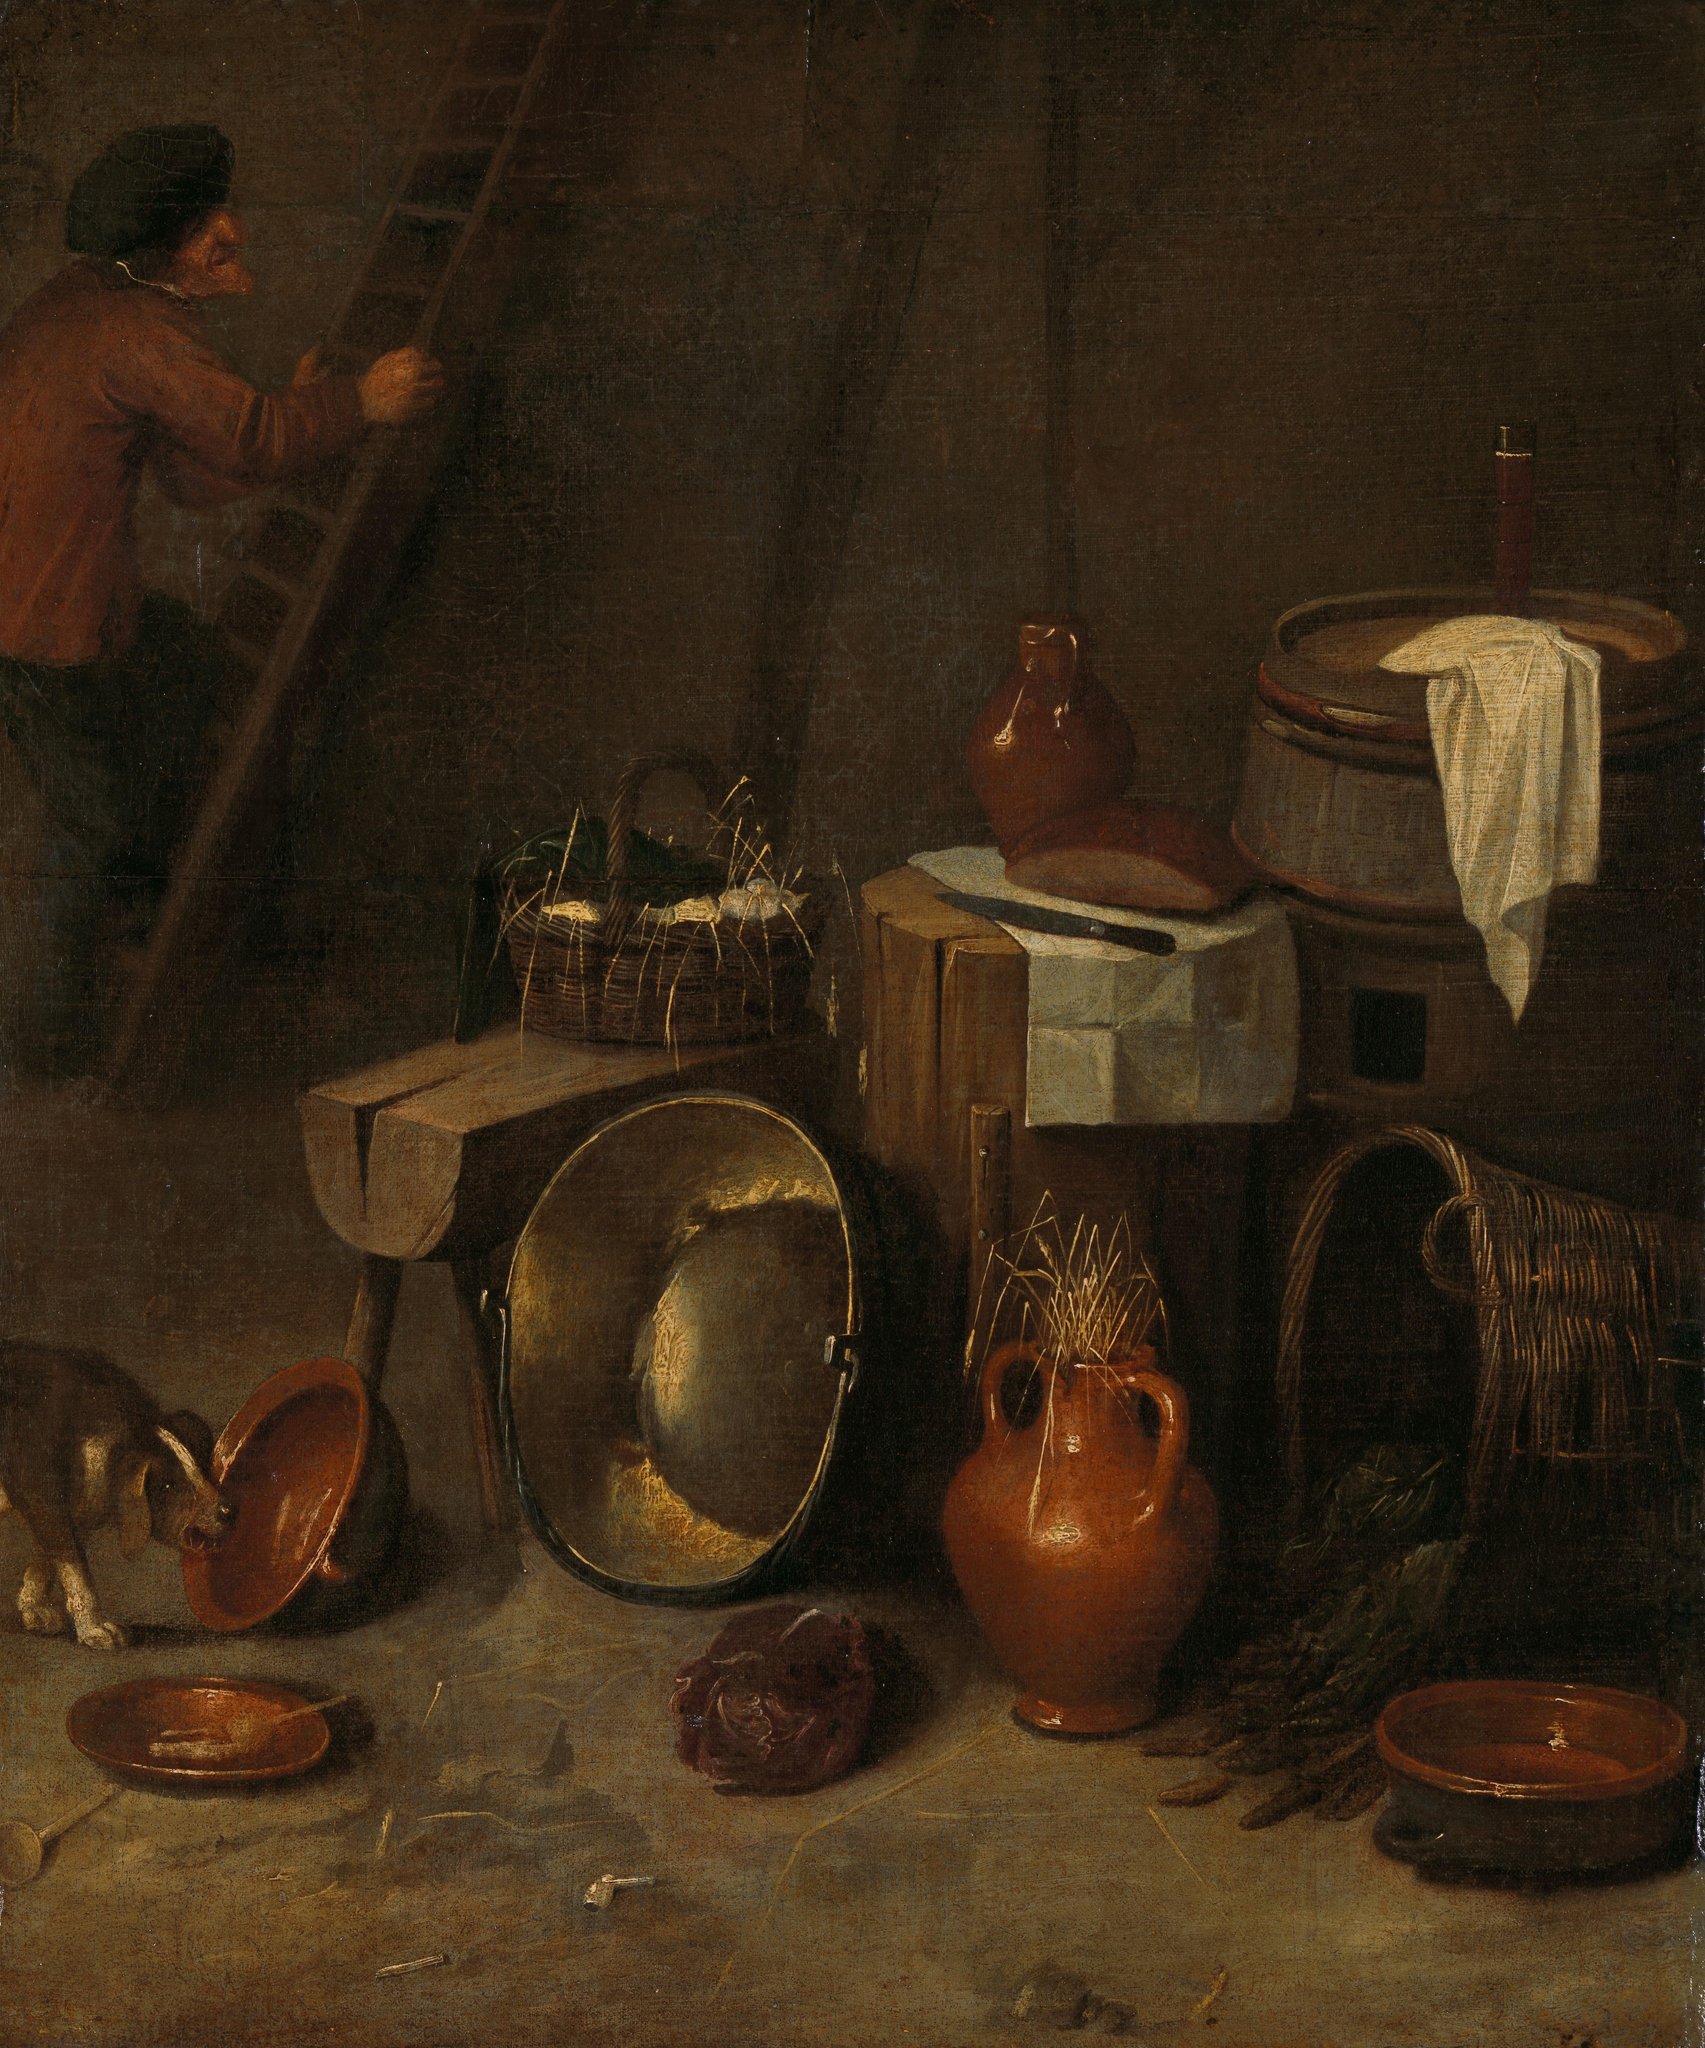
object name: painting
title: Still life in a stable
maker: hendrik potuyl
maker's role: draughtsman, painter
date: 1639-1649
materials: canvas, oil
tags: still life of related objects, stall, stable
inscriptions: signature: ‘H. Potuyl’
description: Stilleven in een stal opgebouwd uit allerlei huishoudelijke voorwerpen: een koperen ketel, een kruik met stro, manden, aardewerken potten en schalen, een kool, een brood met een mes en een kruik op een laken op een hakblok en een pasglas met een servet op een vat. Linksonder gromt een hond naar zijn spiegelbeeld, op de achtergrond bestijgt een boer een ladder.